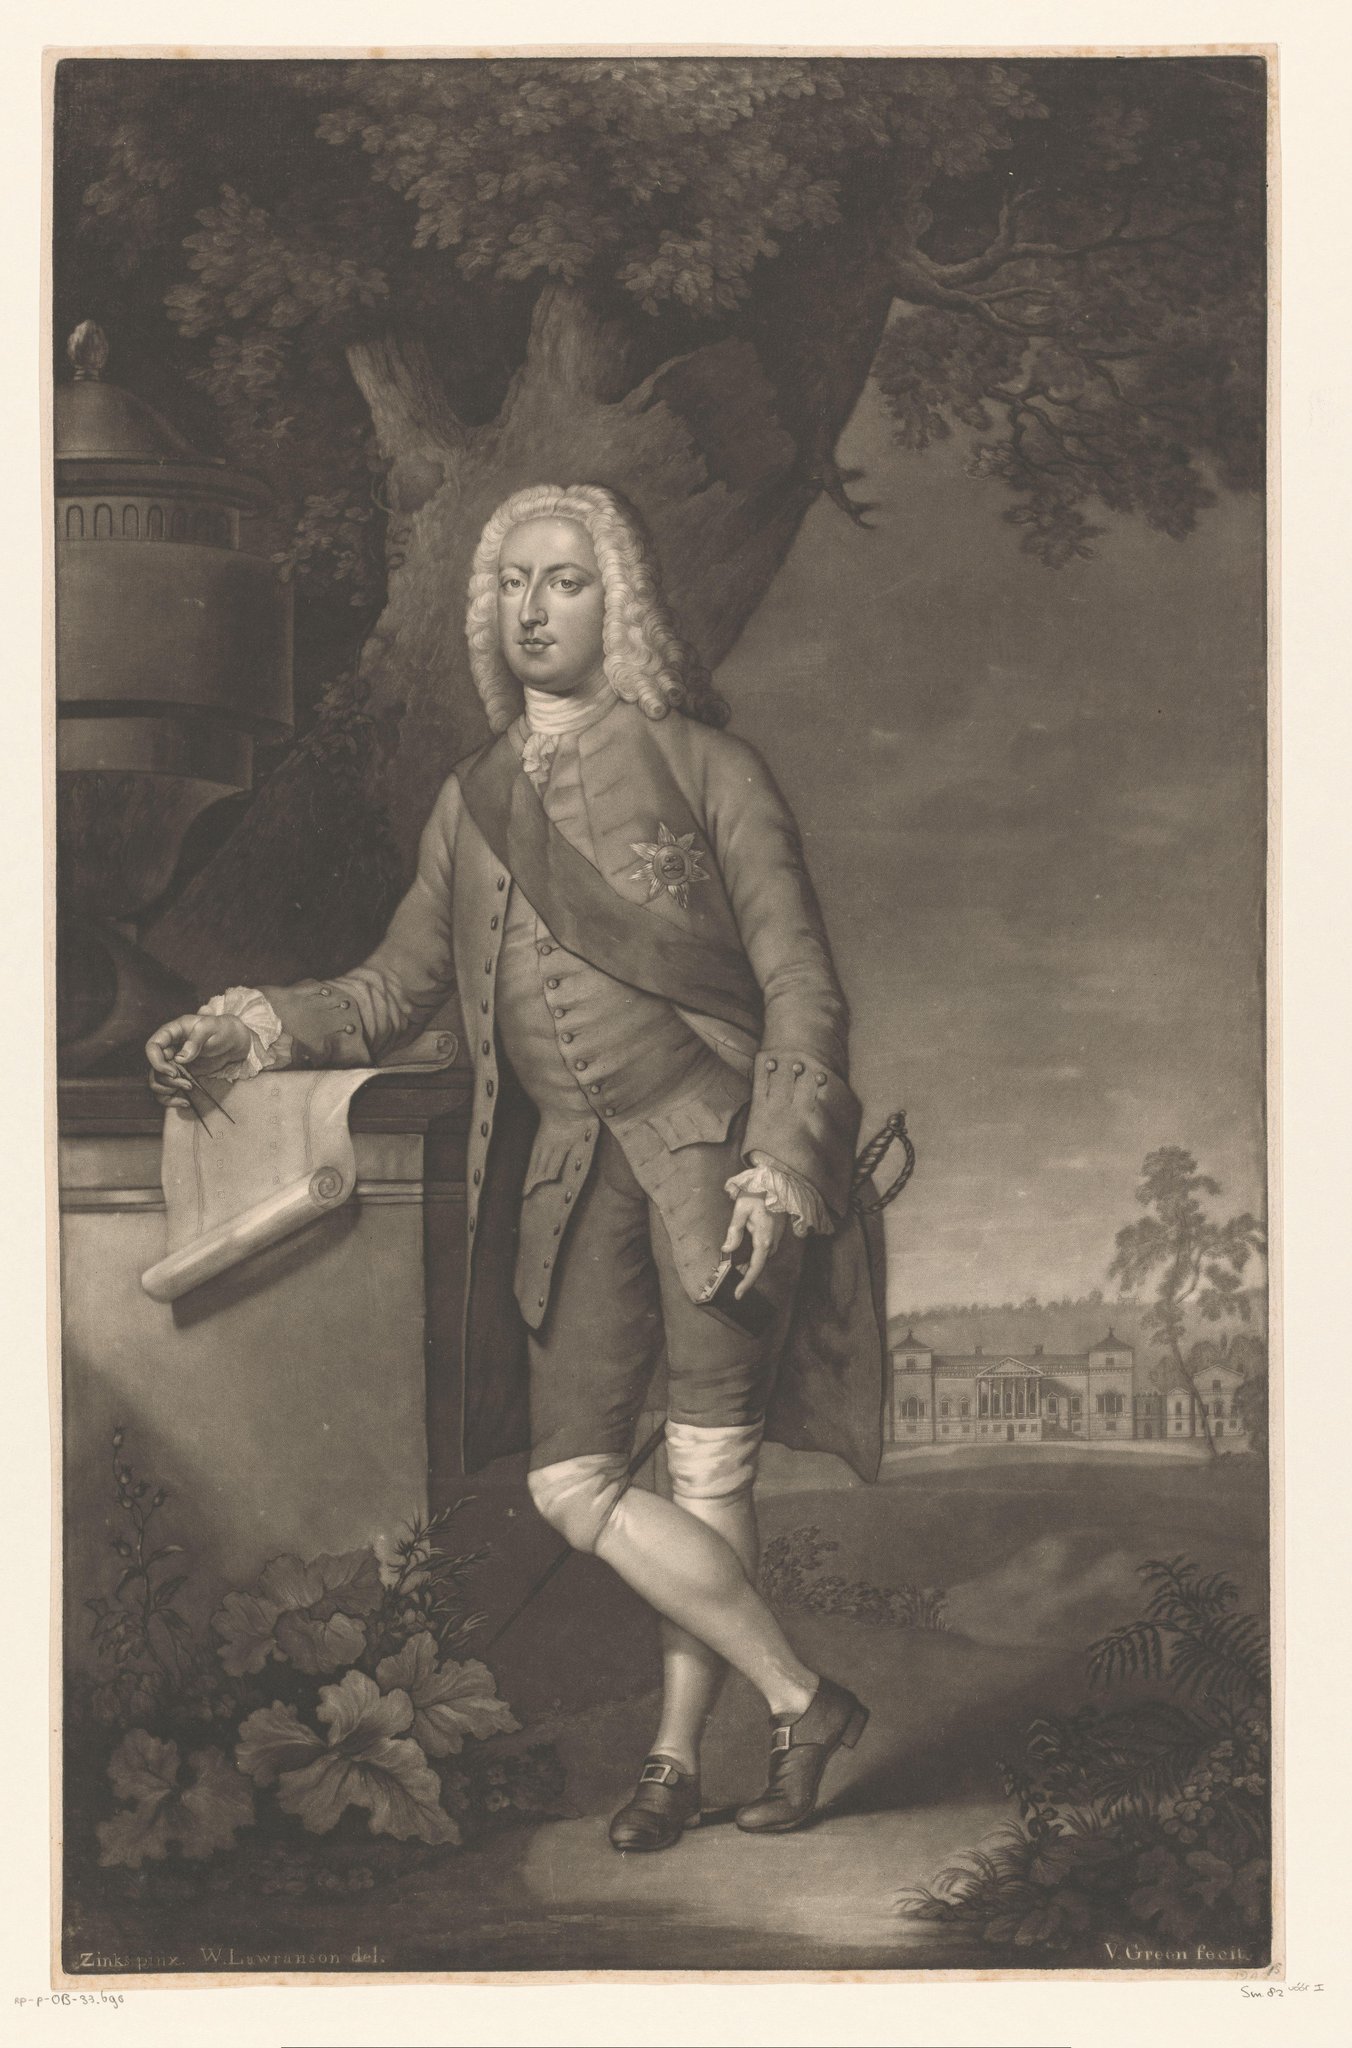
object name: print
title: Portret van Thomas Coke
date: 1767-1780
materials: paper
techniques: mezzotint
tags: earl, thomas coke (1e graaf van leicester), historical persons, compasses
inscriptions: collector's mark: Lugt 240